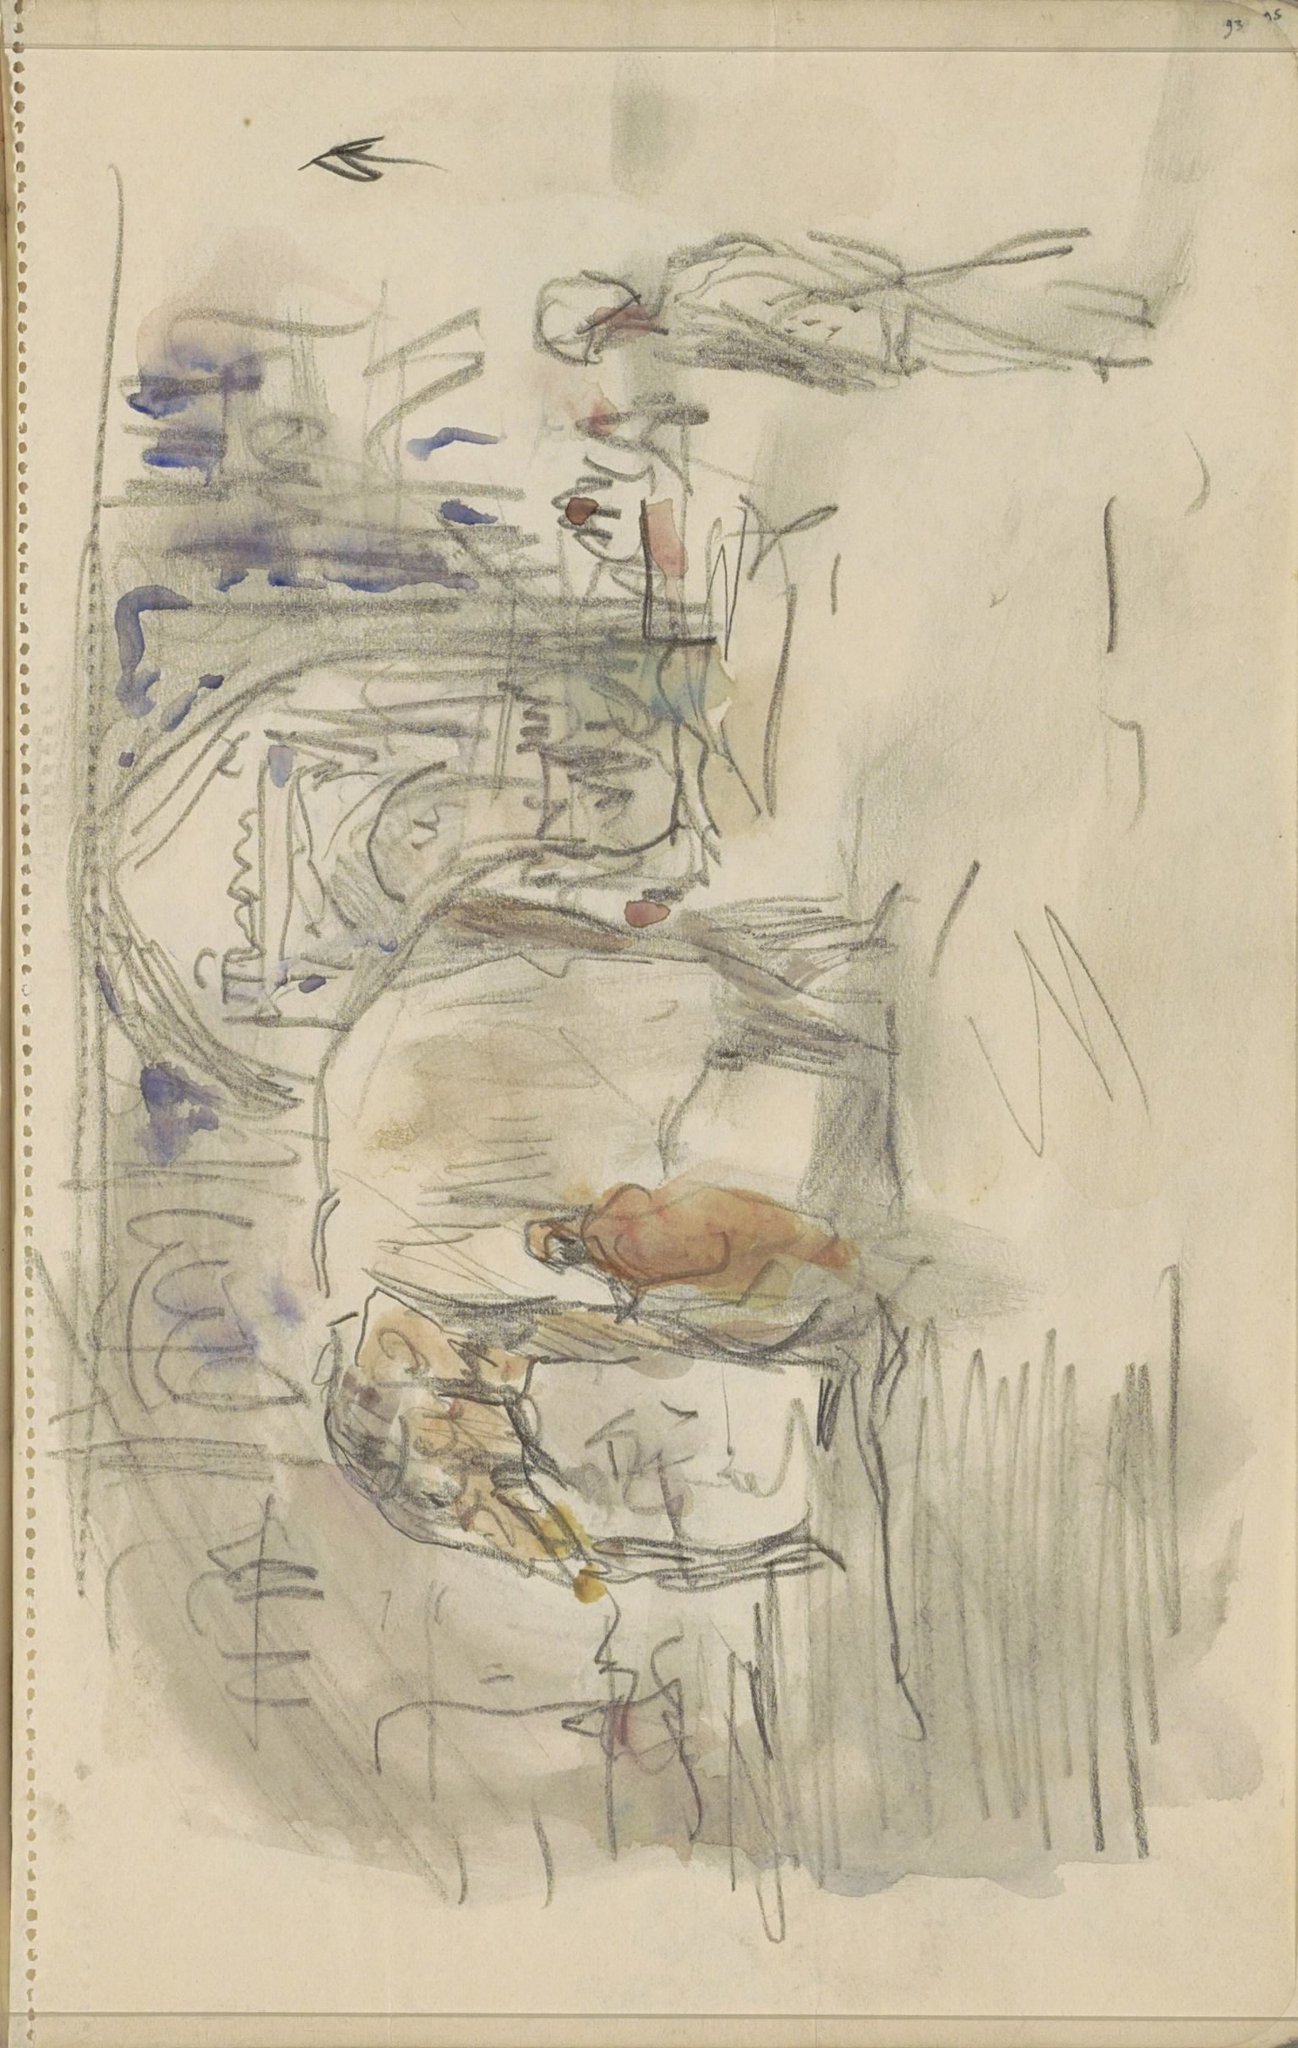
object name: sketchbook leaf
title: Indiër met een olifant bij een poort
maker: marius bauer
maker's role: draughtsman, print maker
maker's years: 1867-1932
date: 1924-1925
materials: paper, pencil, watercolor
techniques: brush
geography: india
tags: arch, archivolt ~ architecture, trunked animals: elephant, street (+ city(-scape) with figures, staffage)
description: Pagina 93 uit een schetsboek met 87 bladen.